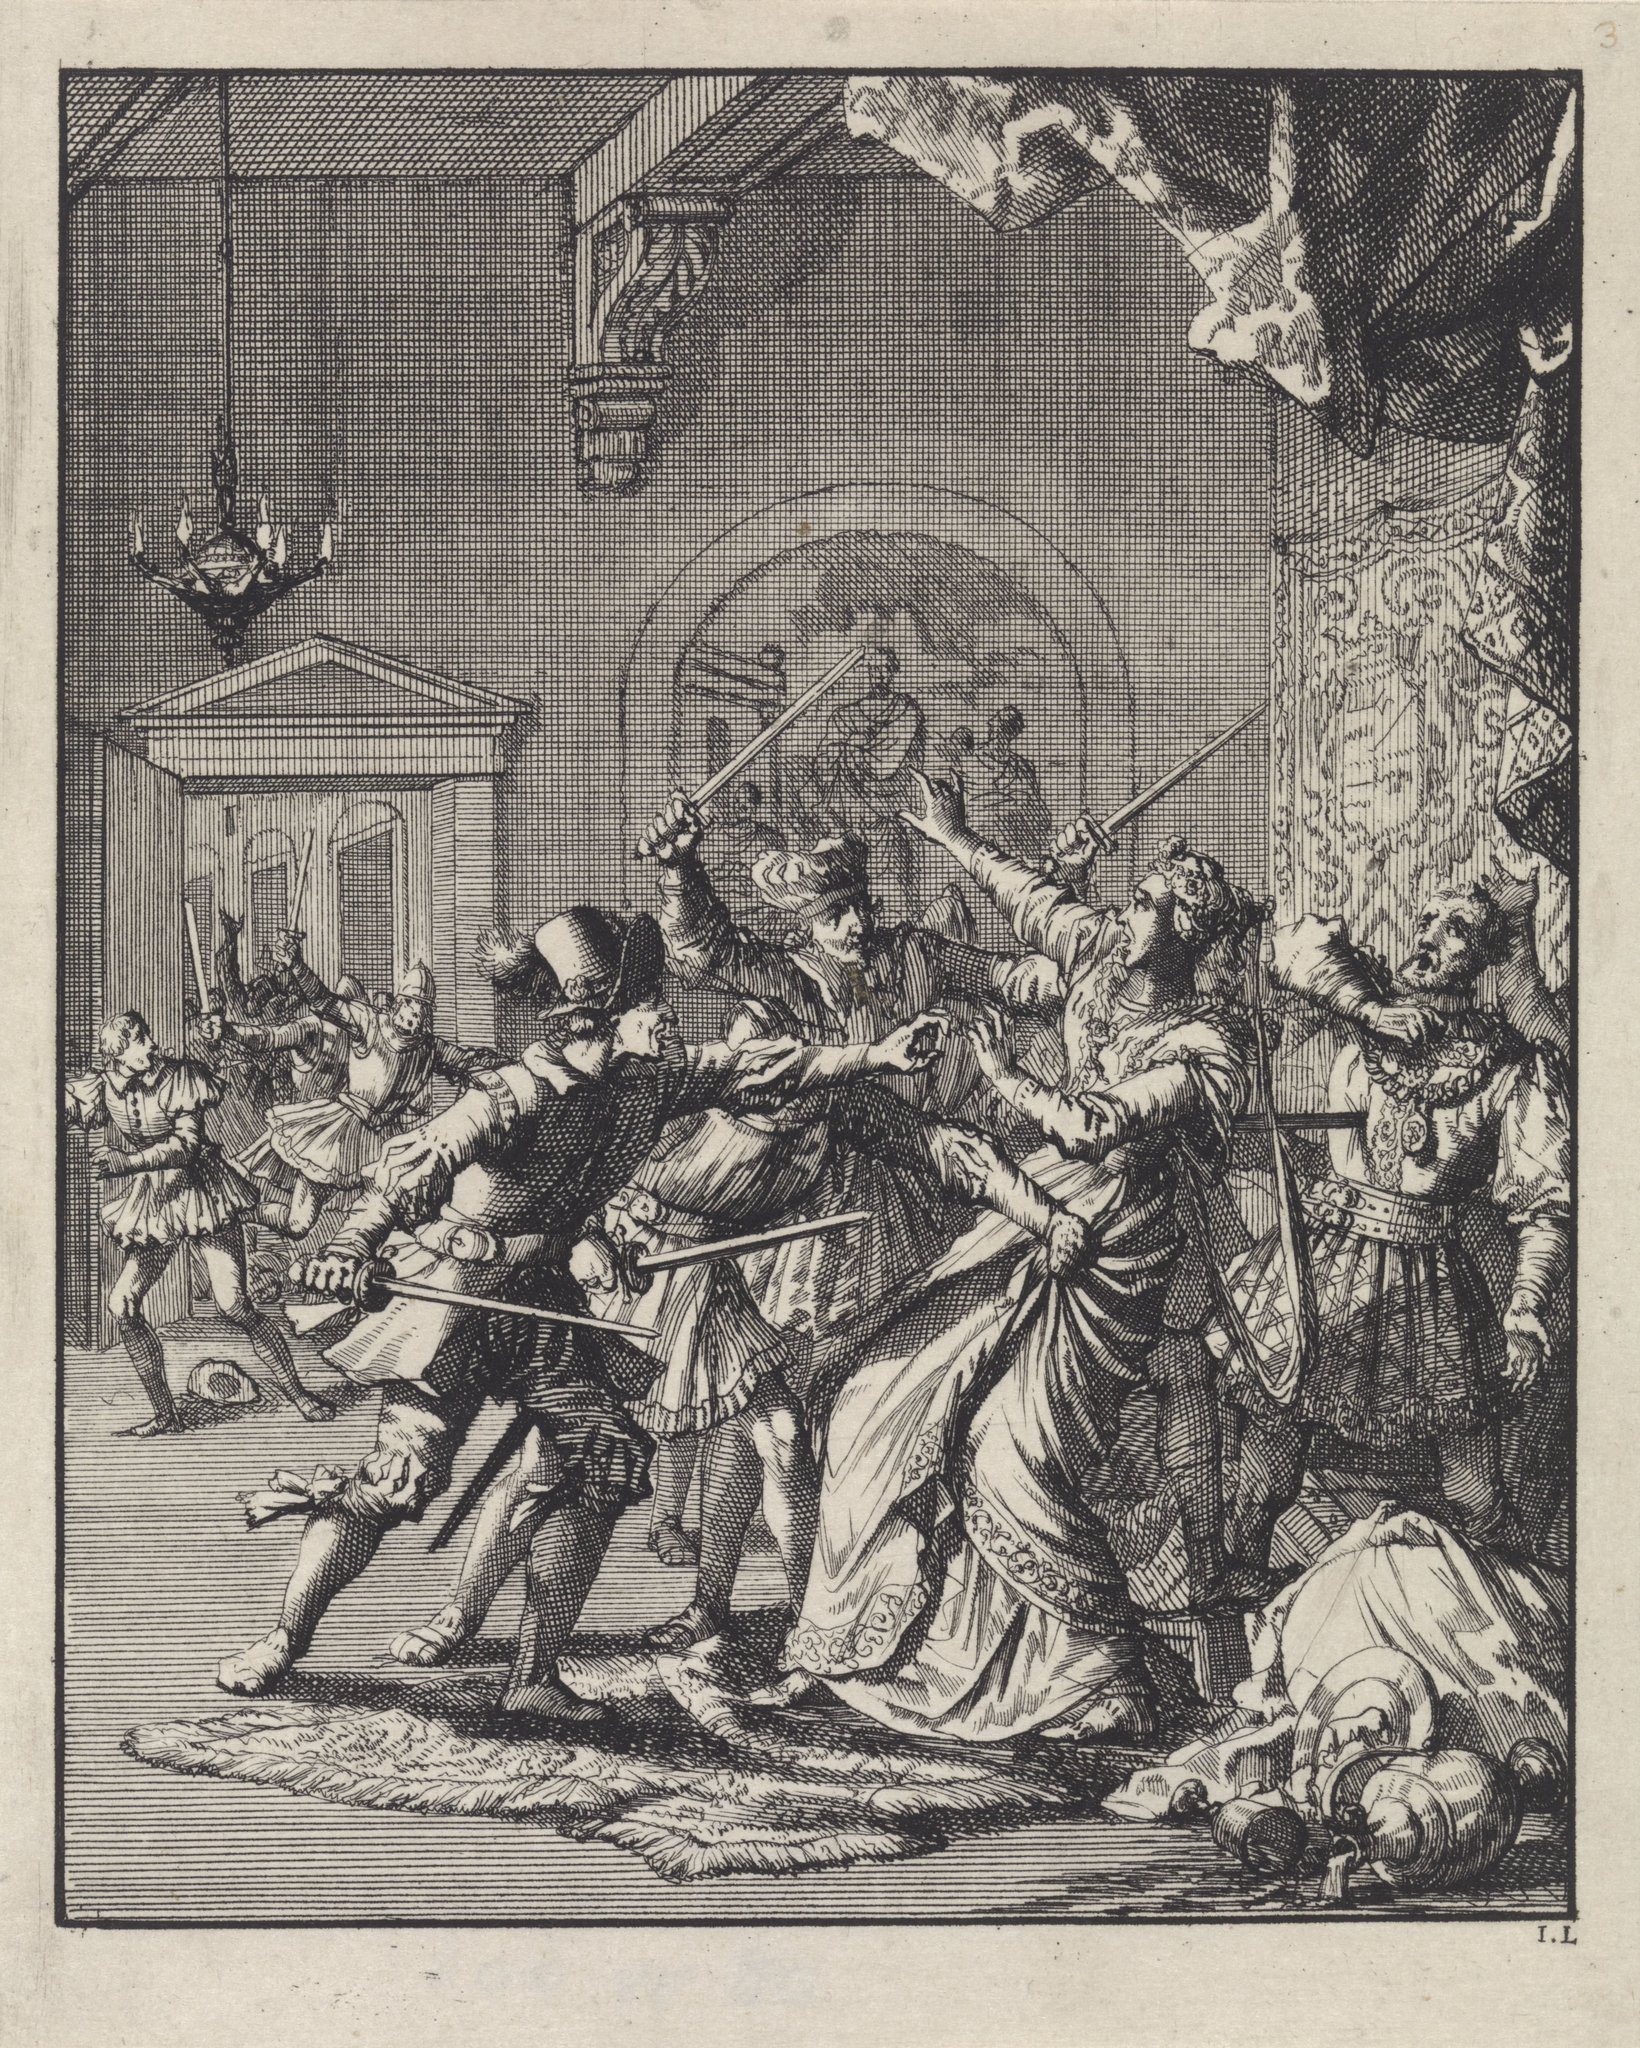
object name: print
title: Jacobus I van Schotland wordt door verraders op gruwelijke wijze vermoord, 1437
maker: jan luyken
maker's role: draughtsman, print maker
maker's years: 1649-1712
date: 1698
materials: paper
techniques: etching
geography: amsterdam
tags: attempt, political murder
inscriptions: collector's mark: Lugt 2228, number: ‘3’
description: Proefdruk van illustratie uit: Bos, Lambert van den. Treur-toonneel der doorluchtige mannen, of Op- en ondergang der grooten, 3 delen. Amsterdam: Jan Claesz ten Hoorn, 1698, dl. I.